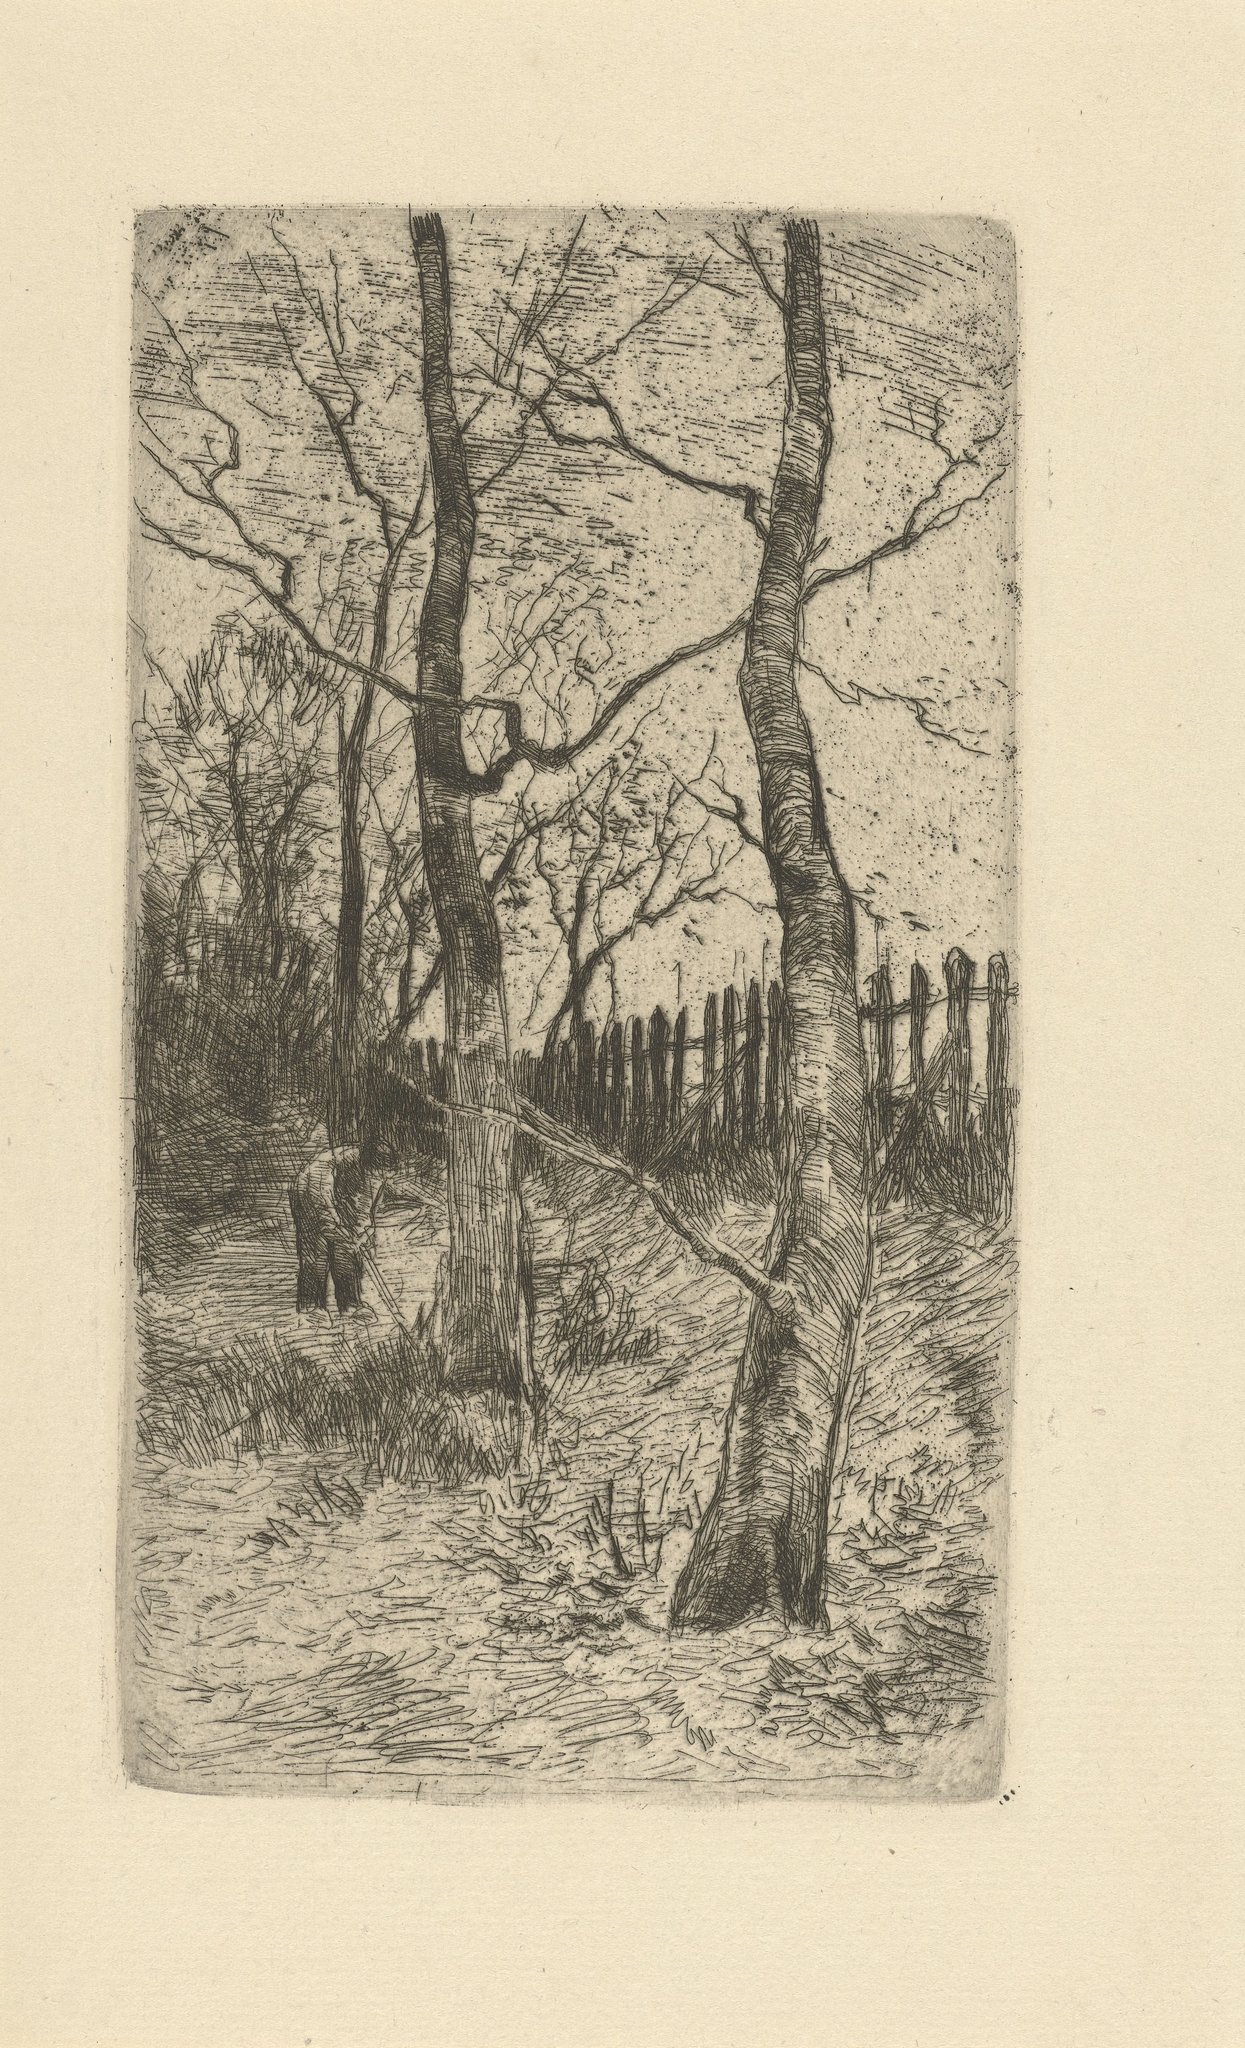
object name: print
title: Houthakker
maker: anton mauve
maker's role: draughtsman, painter, print maker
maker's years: 1838-1888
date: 1848-1888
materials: paper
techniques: etching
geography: netherlands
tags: woodcutting, woodcutter ~ forestry, fence, wall, paling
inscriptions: inscription: ‘A. Mauve. Nederlandsch Etsclub 1867’, collector's mark: Lugt 2228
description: Twee achter elkaar staande bomen. Bij de tweede boom een voorover gebogen houthakker. Op de achtergrond kreupelhout en rechts een hek.